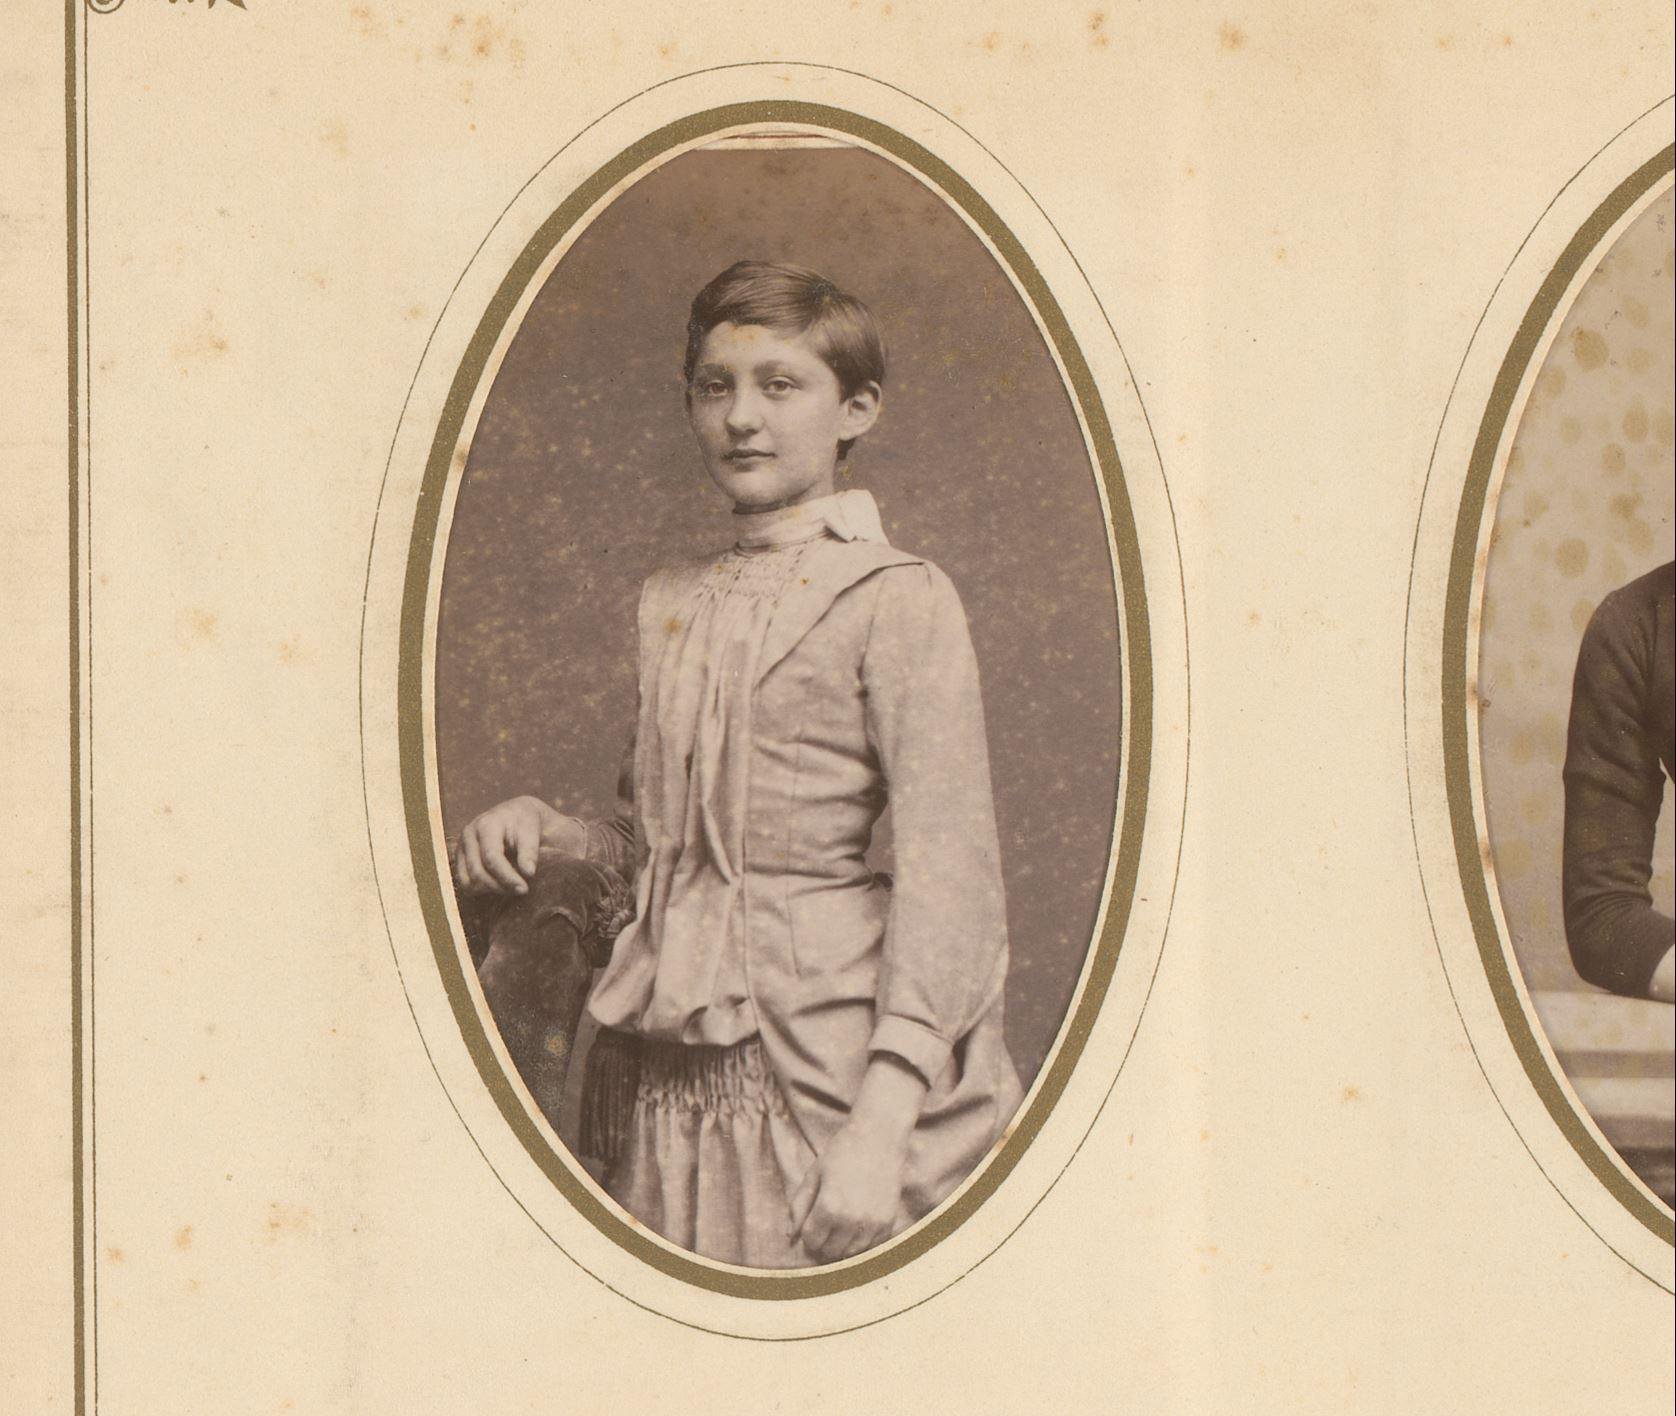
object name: photograph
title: Portret van een meisje, staand bij een stoel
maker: elkan sanders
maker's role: fotograaf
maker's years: 1848-1923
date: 1886-1891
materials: cardboard, photographic support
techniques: albumen print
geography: groningen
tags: historical persons - bb - woman, girl (child between toddler and youth), standing figure - aa - female human figure, chair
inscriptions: inscription: ‘Elkan Sanders Jr/ GRONINGEN/ Oosterstraat/ 204./ hoek Donkersgang.’